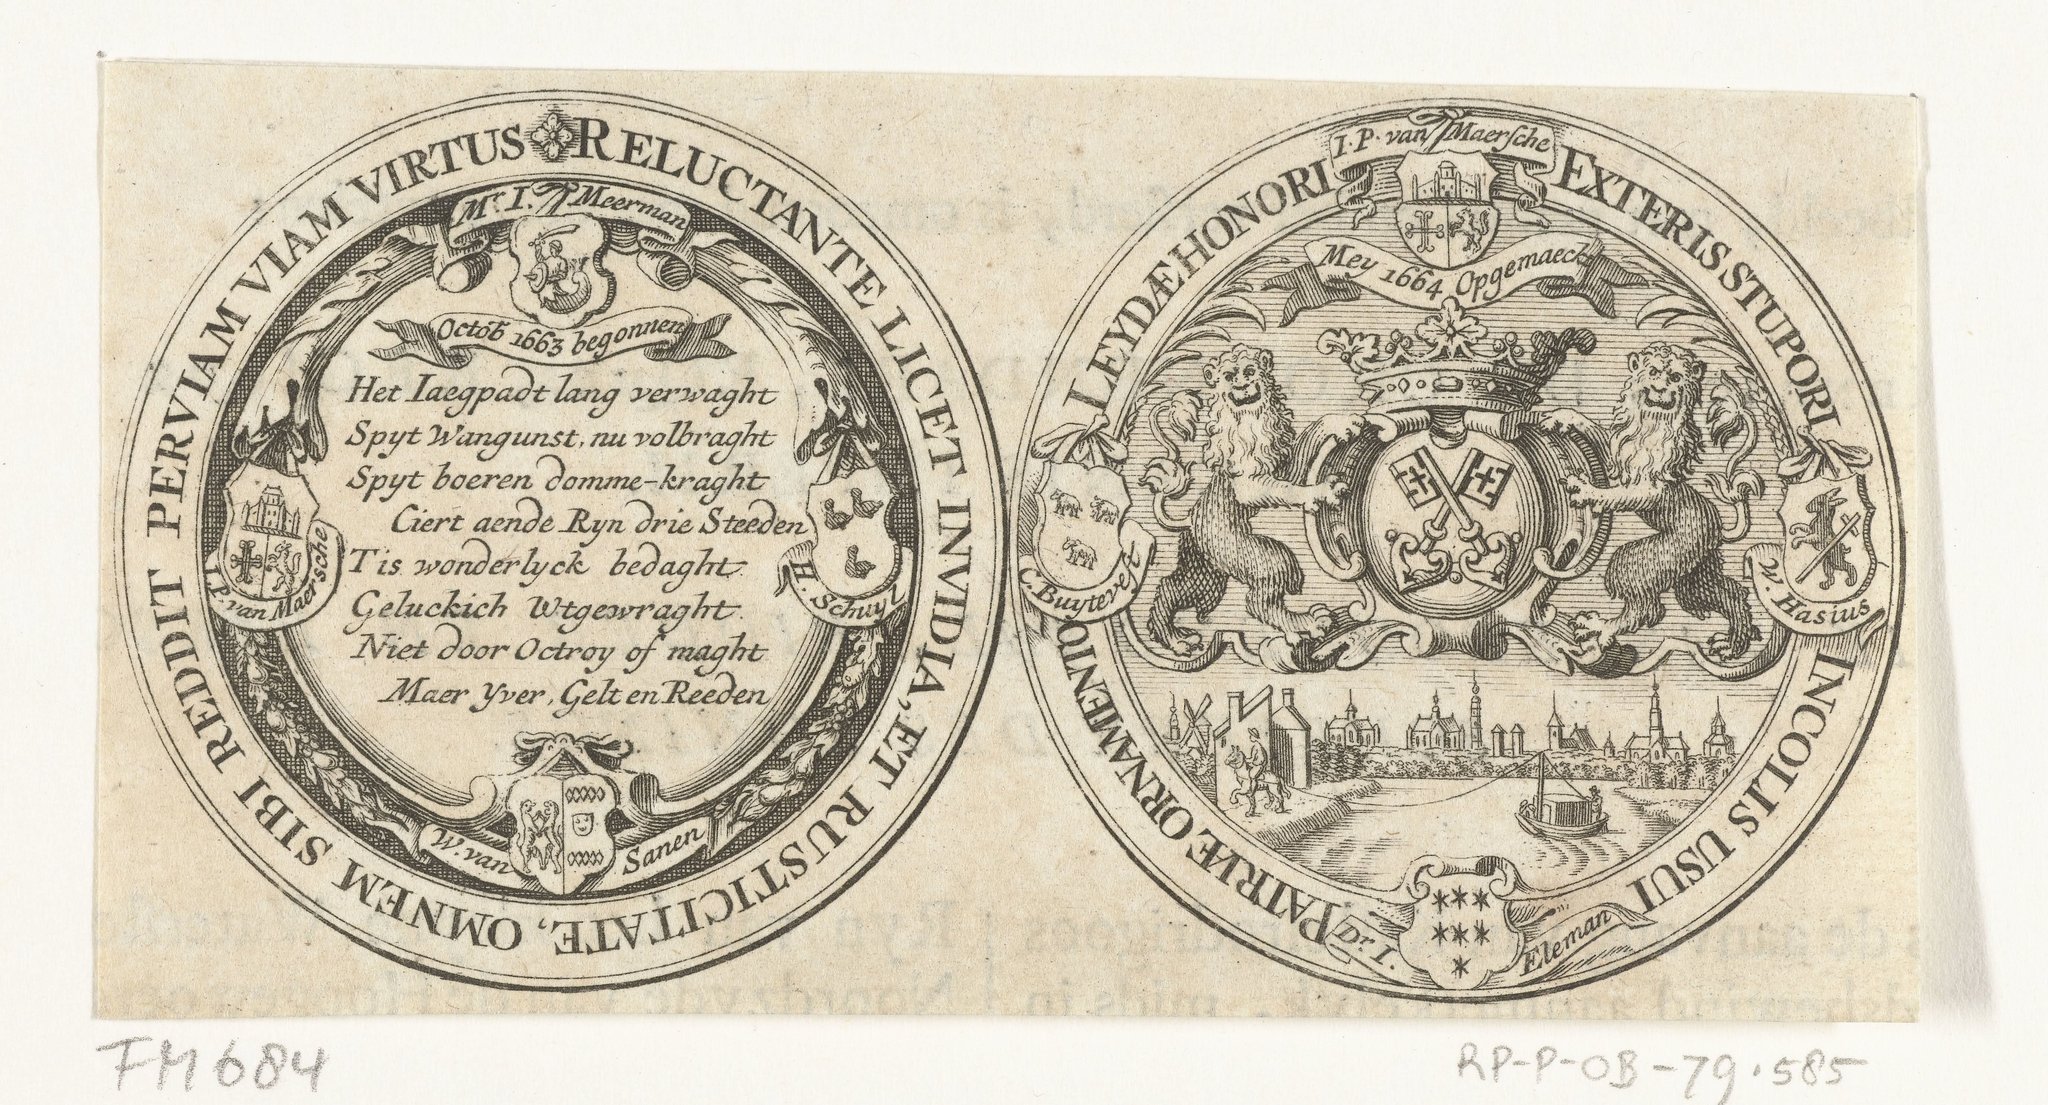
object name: historical object representation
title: Penning bij de voltooiing van het jaagpad van Leiden naar Utrecht, 1664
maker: Anonymous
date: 1724-1726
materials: paper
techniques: etching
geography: northern netherlands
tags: medal (considered as a piece of sculpture, regardless of its specific function), tow-boat, towing-barge, leiden, utrecht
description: Penning bij de voltooiing van het jaagpad van Leiden naar Utrecht, 1664. Zilveren penning. Voorzijde: opschrift binnen krans met vier wapenschilden boven wimpel met opschrift, binnen omschrift. Keerzijde: gekroond wapenschild van Leiden geflankeerd door twee leeuwen boven afbeelding van trekschuit voor stad, binnen rand met omschrift en vier wapenschilden.